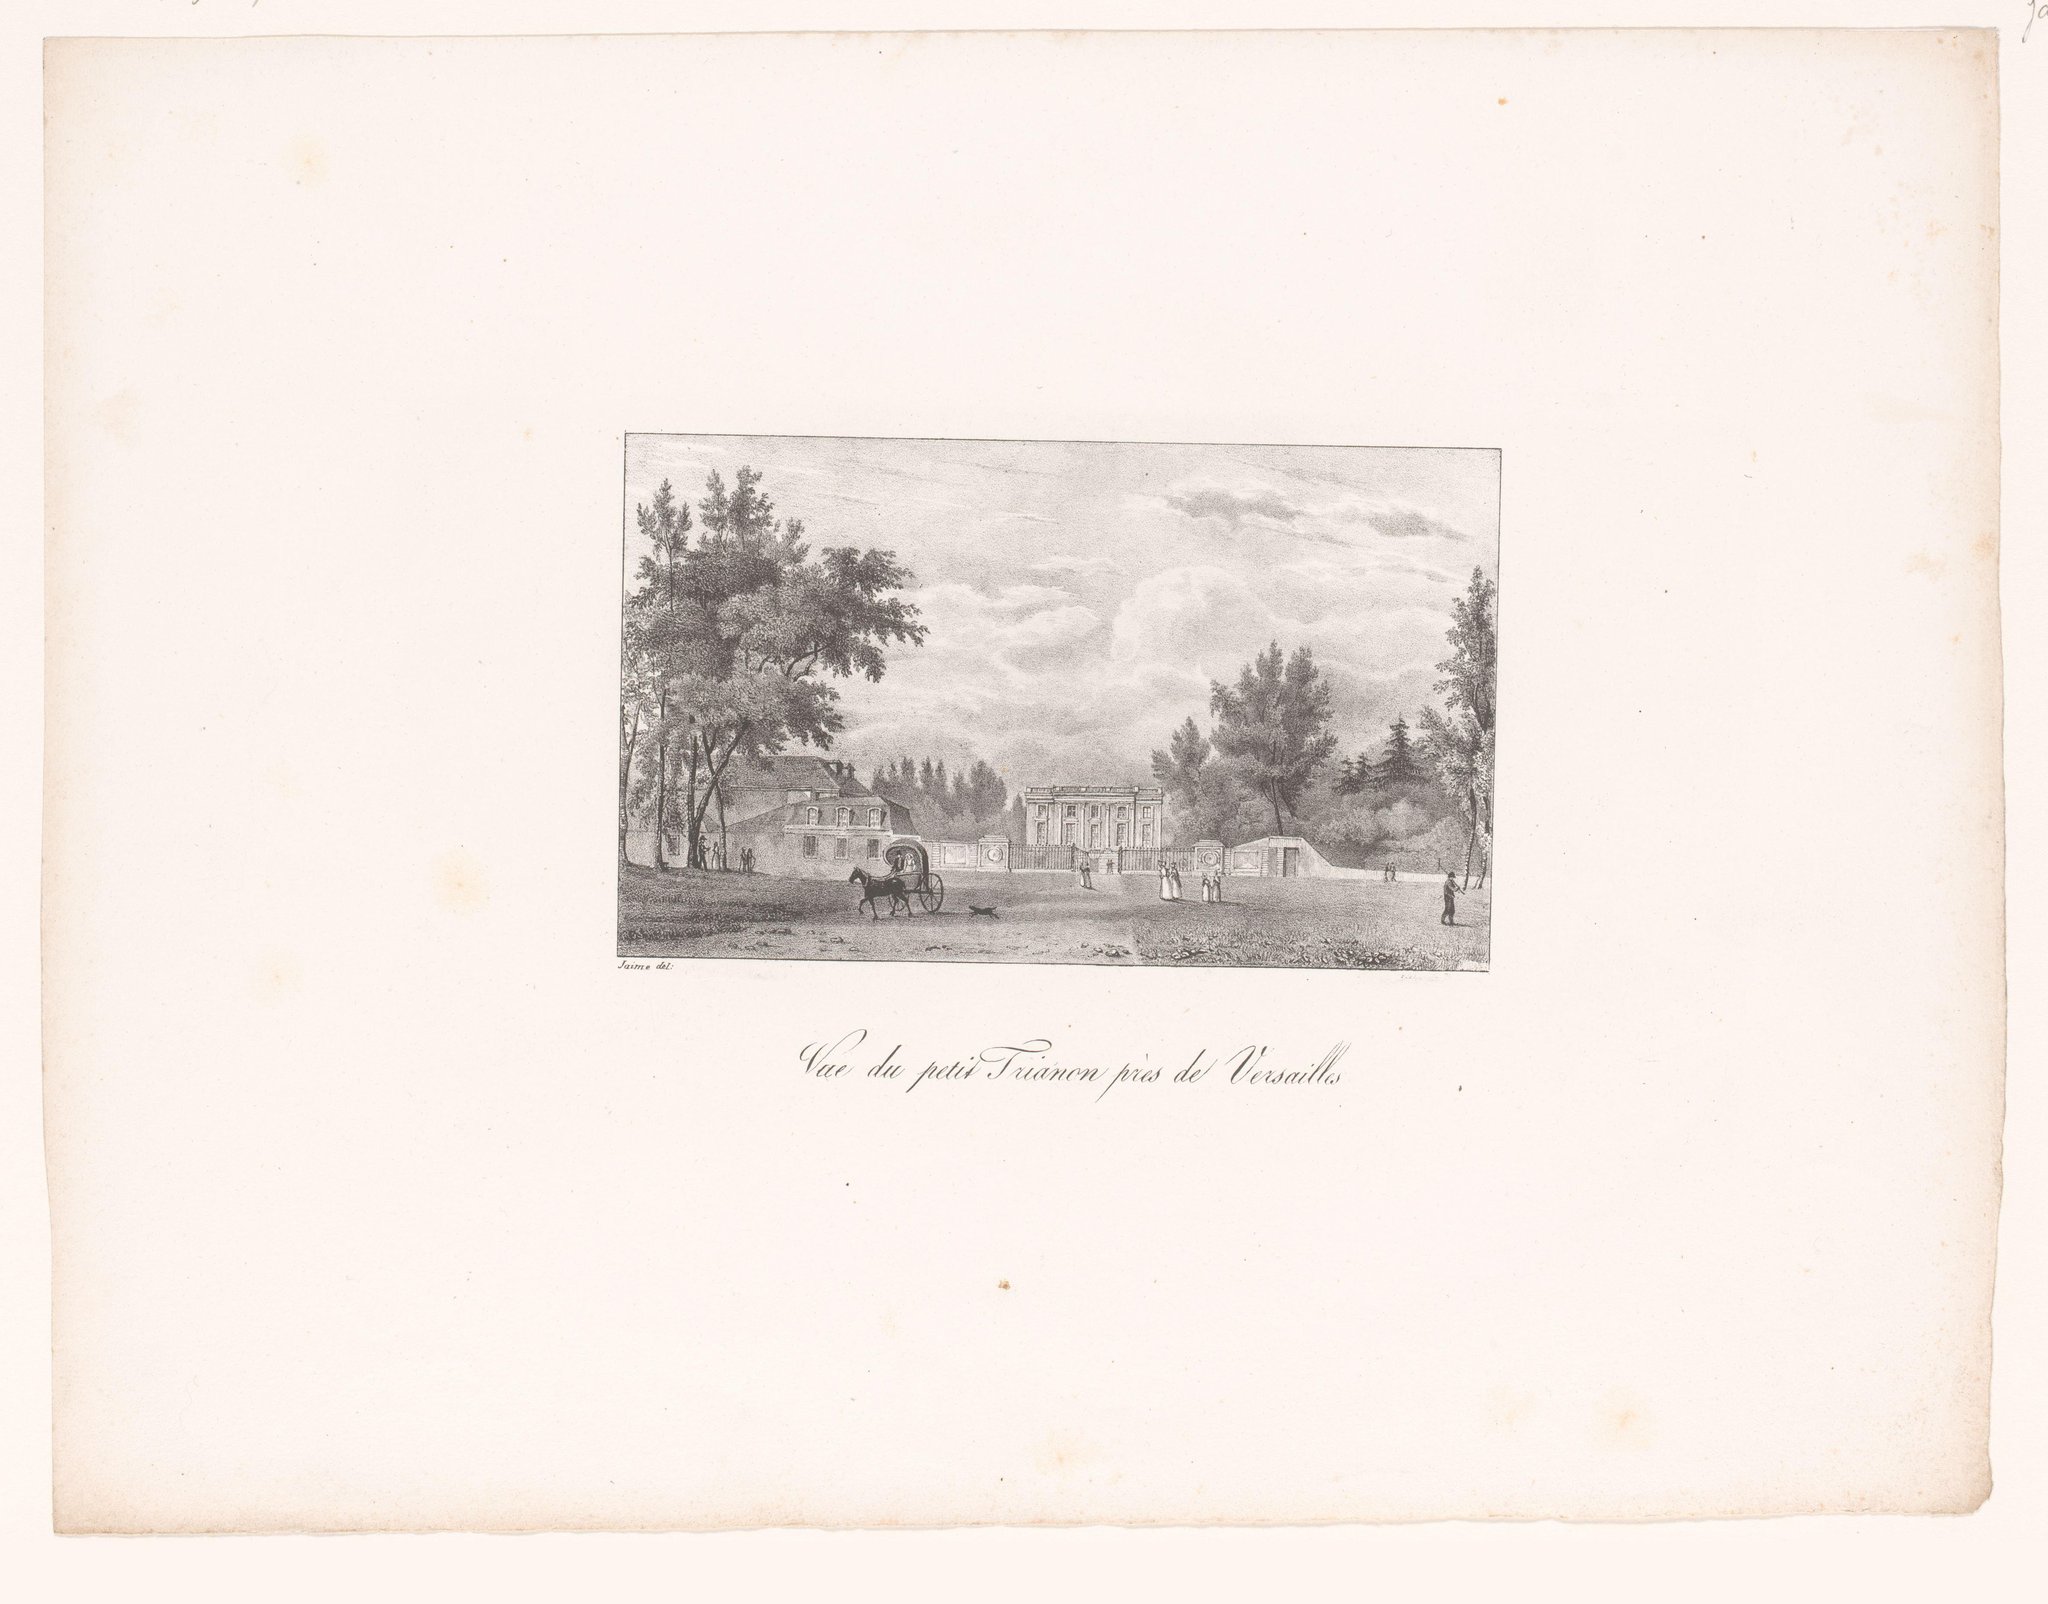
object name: print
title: Zicht op het Château du Petit Trianon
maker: ernest jaime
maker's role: print maker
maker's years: 1802-1884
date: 1827-1828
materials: paper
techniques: lithograph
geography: paris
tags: palace, public gardens, park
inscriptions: collector's mark: Lugt 2228a